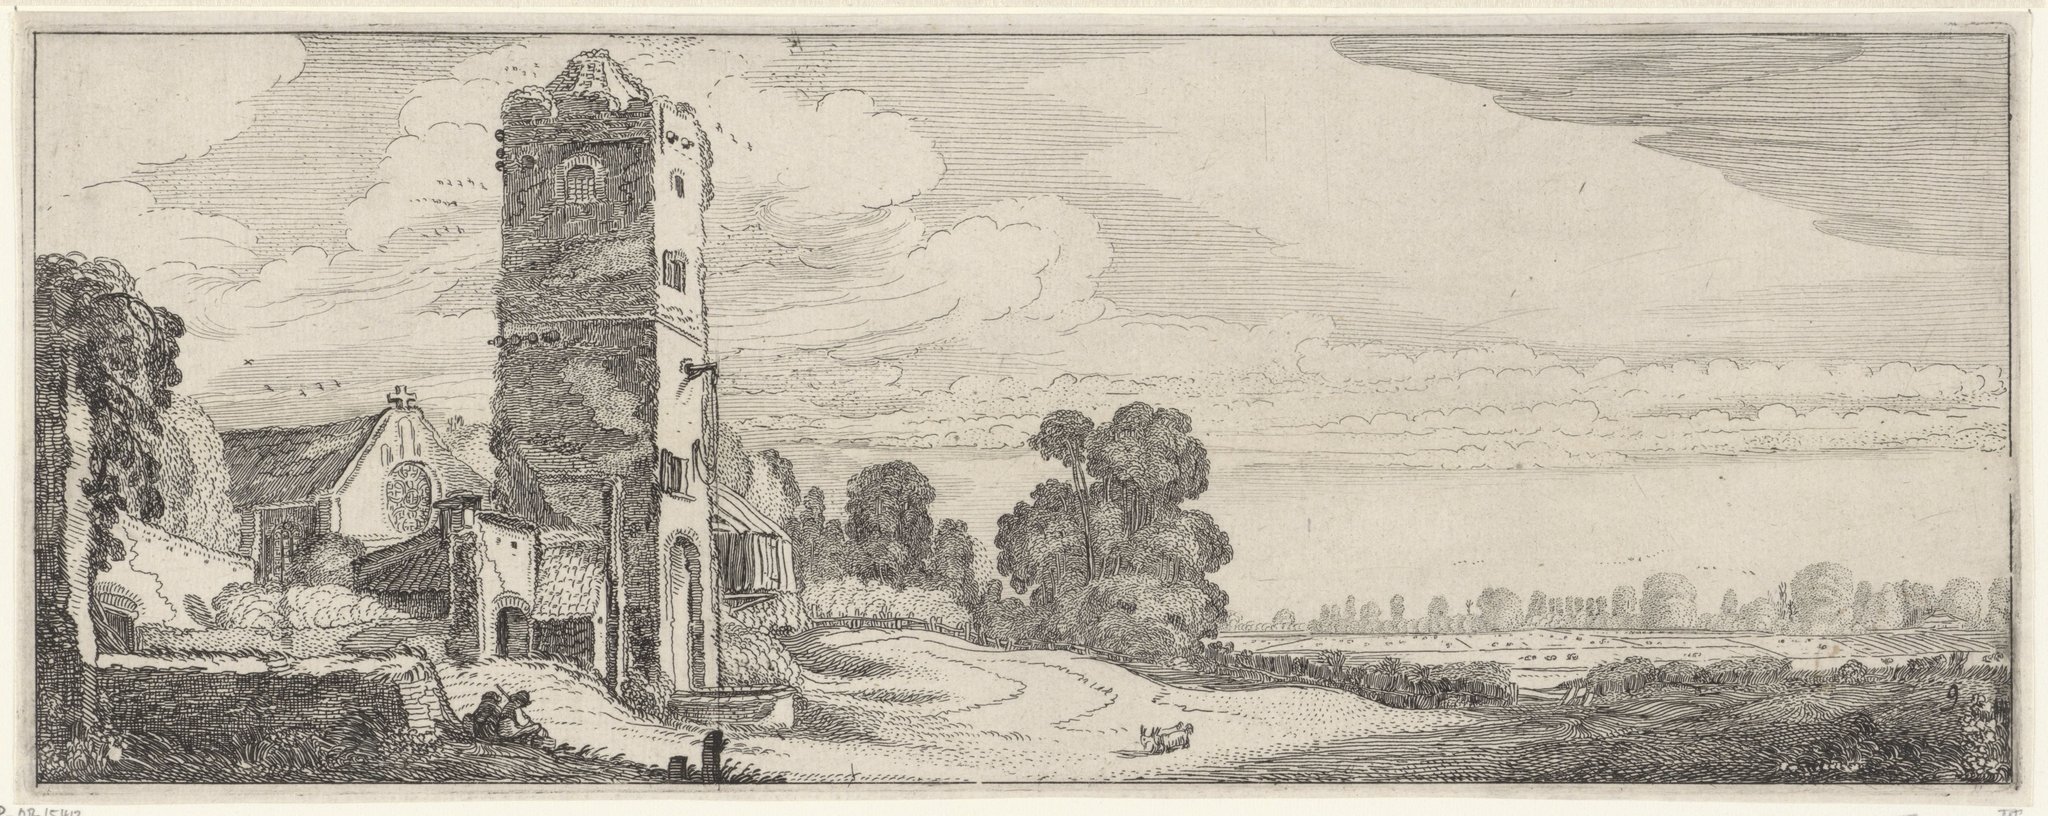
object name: print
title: Amoenissimae aliquot Regiunculae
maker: jan van de velde (ii)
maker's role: draughtsman, painter, print maker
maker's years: 1593-1641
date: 1615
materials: paper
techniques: etching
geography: northern netherlands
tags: landscape with tower or castle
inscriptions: collector's mark: Lugt 240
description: Landschap met een vierkante toren. Negende prent uit een serie van achttien.